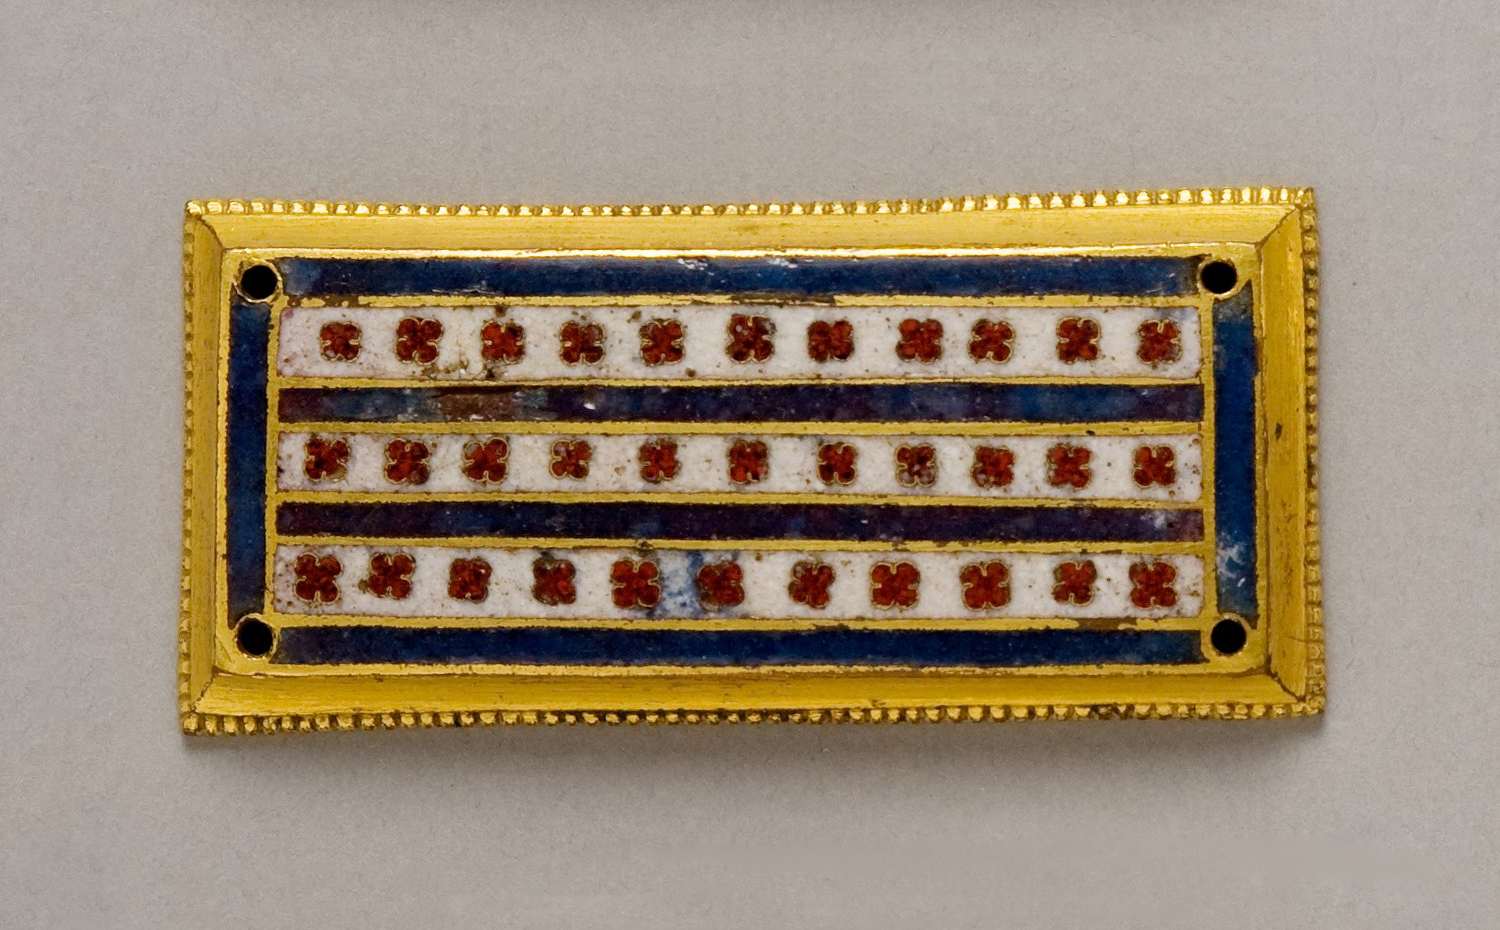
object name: plaque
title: Plaque from a Reliquary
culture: german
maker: master of the virgin mary's reliquary casket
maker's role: artist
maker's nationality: german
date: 1201-1233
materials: gilt copper, enamel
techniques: enamel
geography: germany